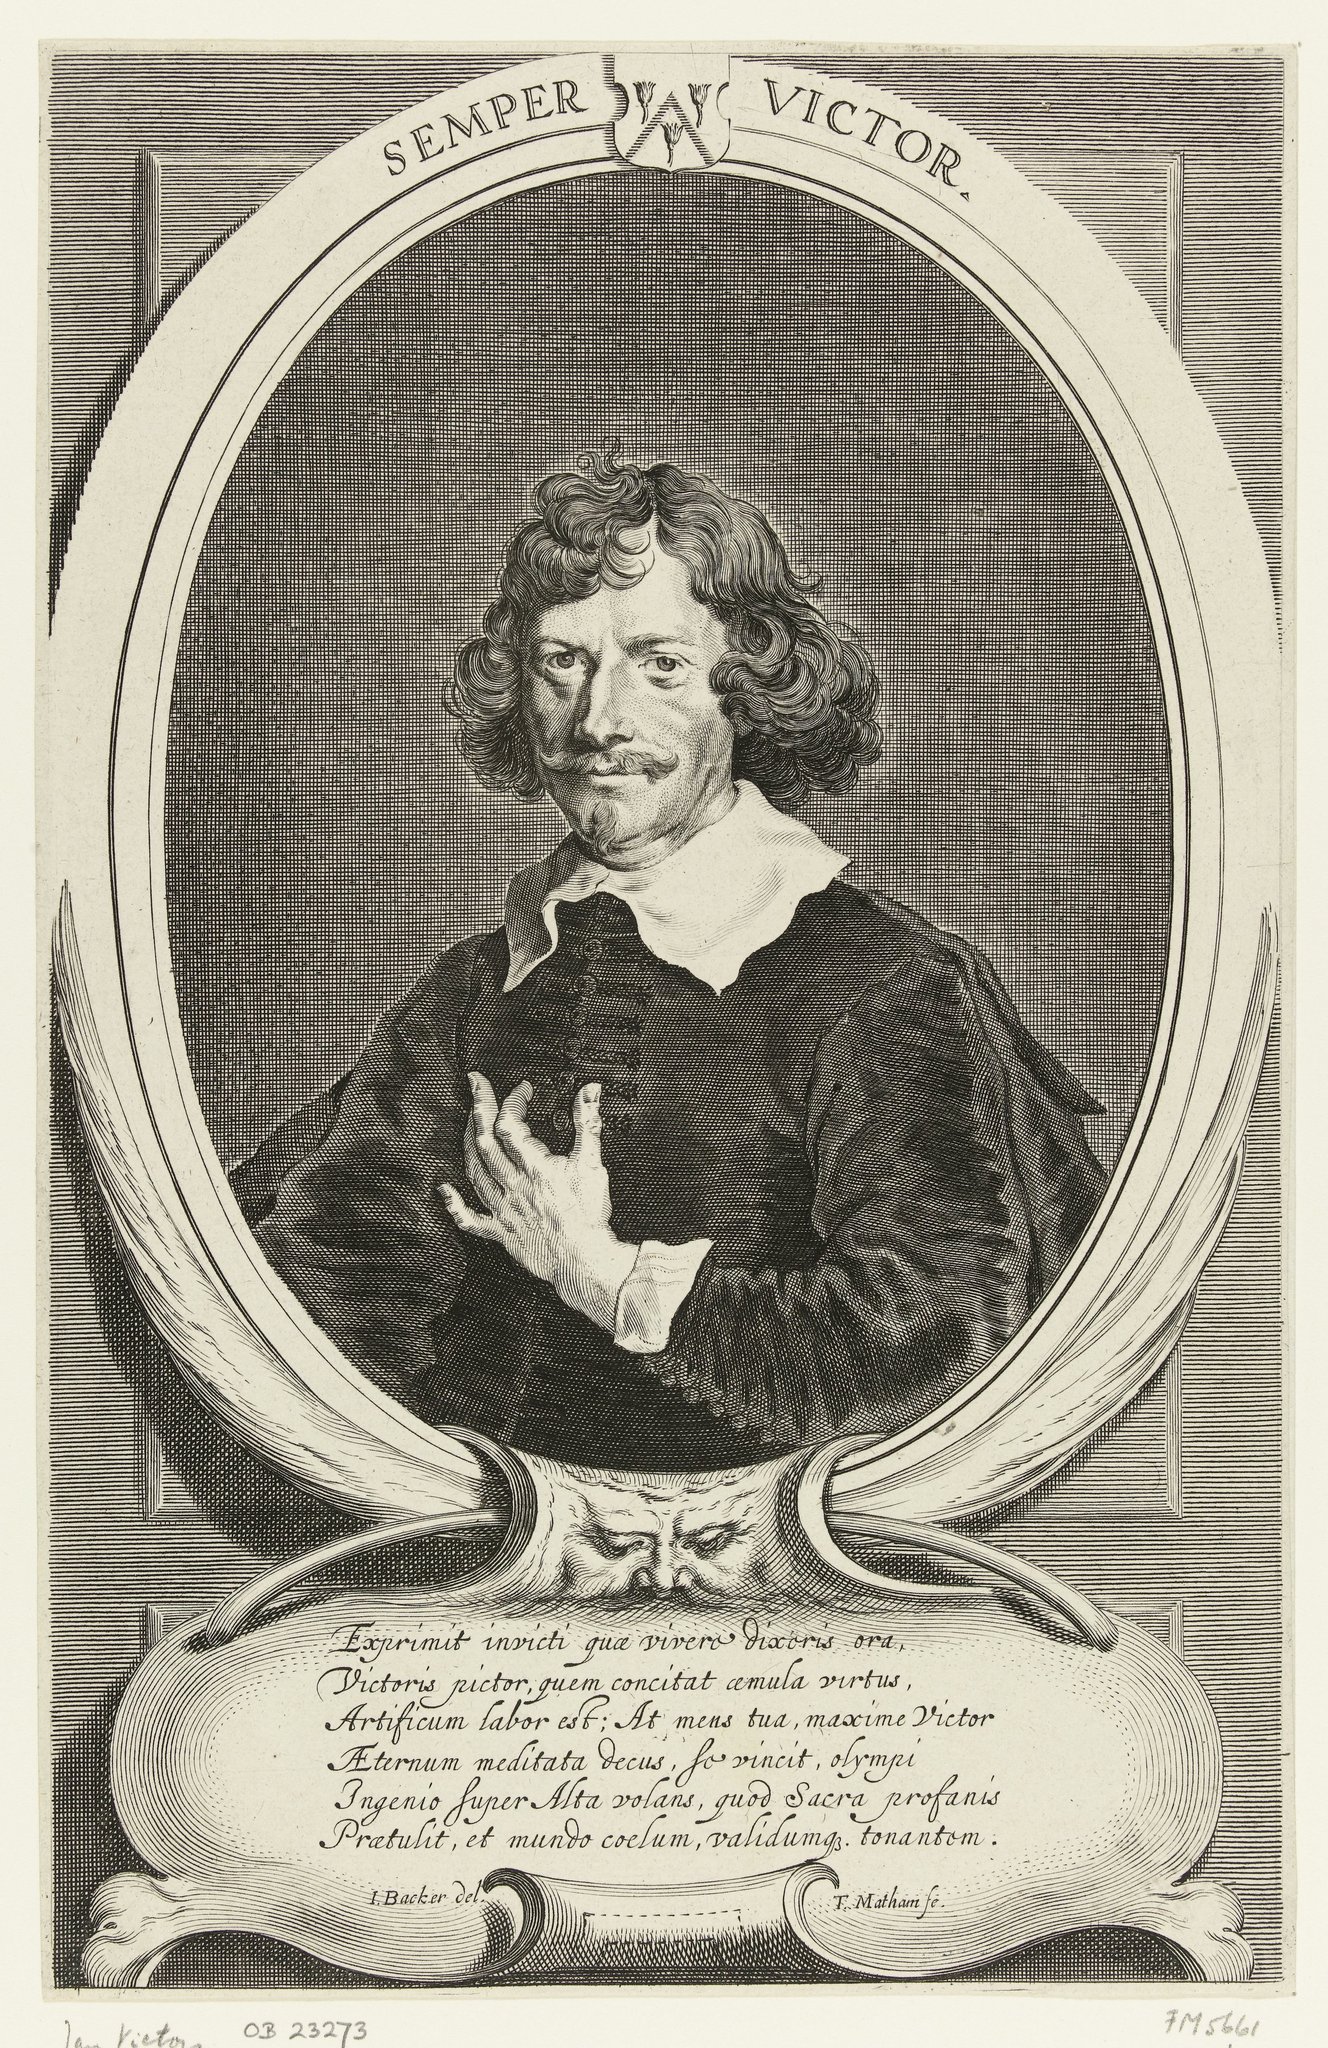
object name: print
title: Portret van Jan Victors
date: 1629-1676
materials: paper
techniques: engraving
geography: northern netherlands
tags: amsterdam, painter, jan victors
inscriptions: collector's mark: Lugt 240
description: Portret van de Amsterdamse schilder Jan Victors.